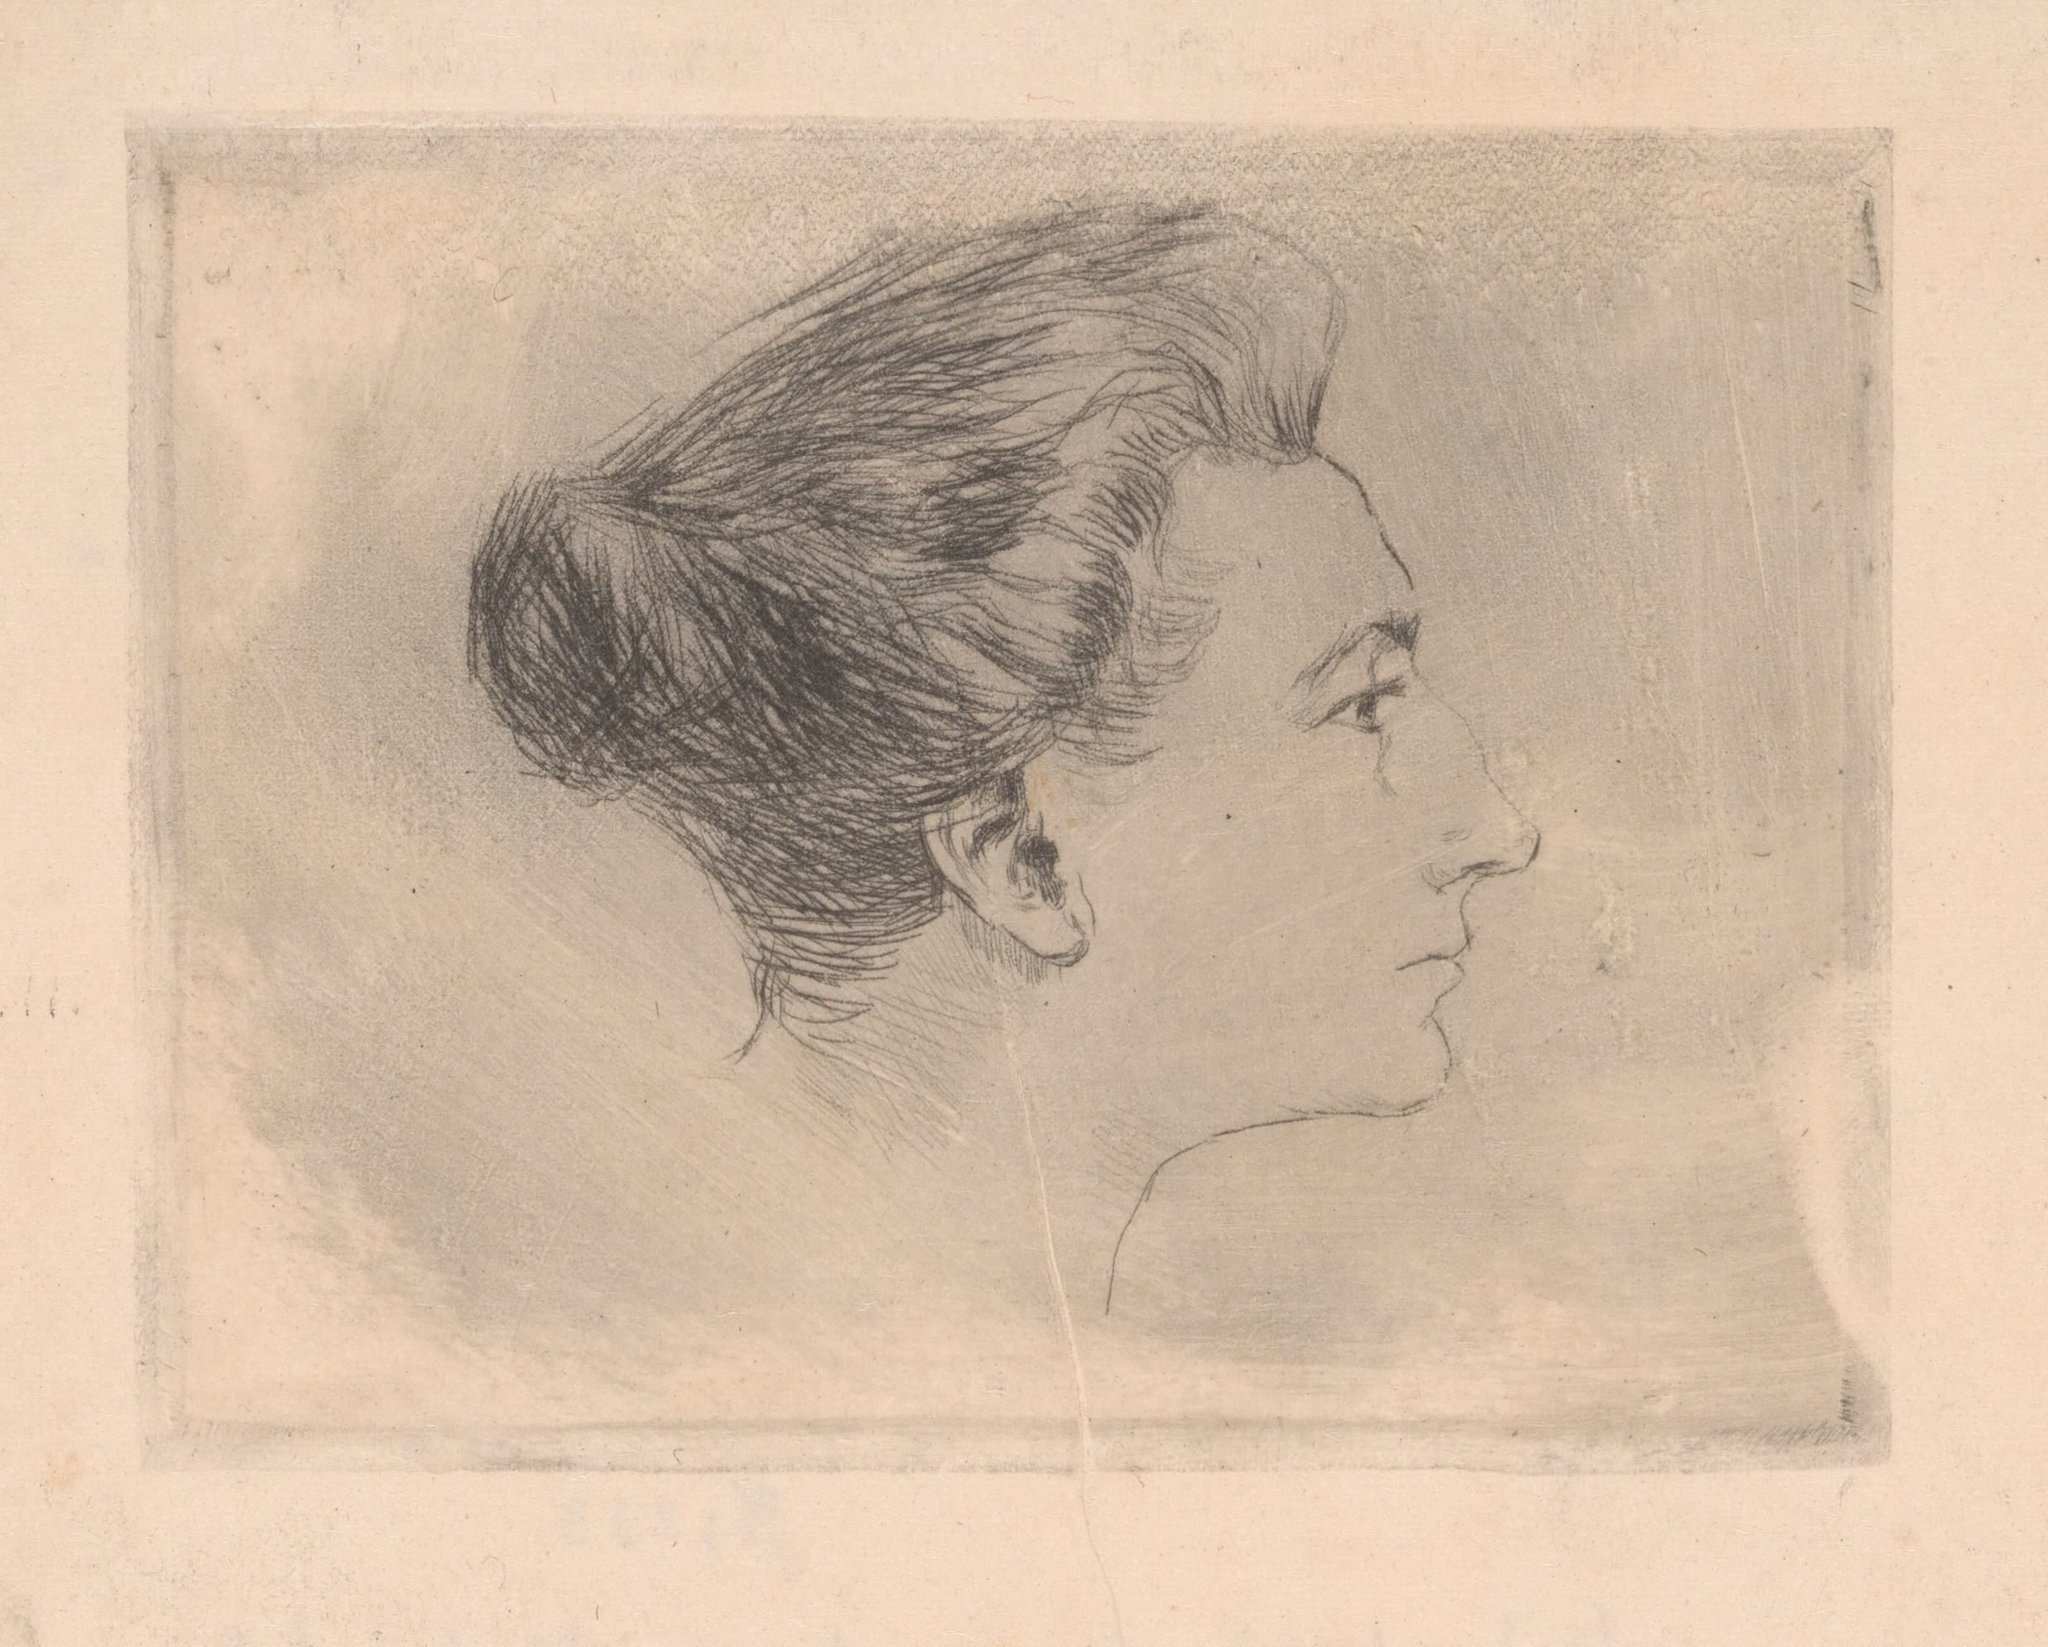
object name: print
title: Vrouwenhoofd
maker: maria hubrecht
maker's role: print maker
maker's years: 1865-1950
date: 1875-1950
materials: paper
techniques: etching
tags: head (human) - aa - female human figure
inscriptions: : ‘Uit plakboek van Maria Hubrecht’, collector's mark: Lugt 2228